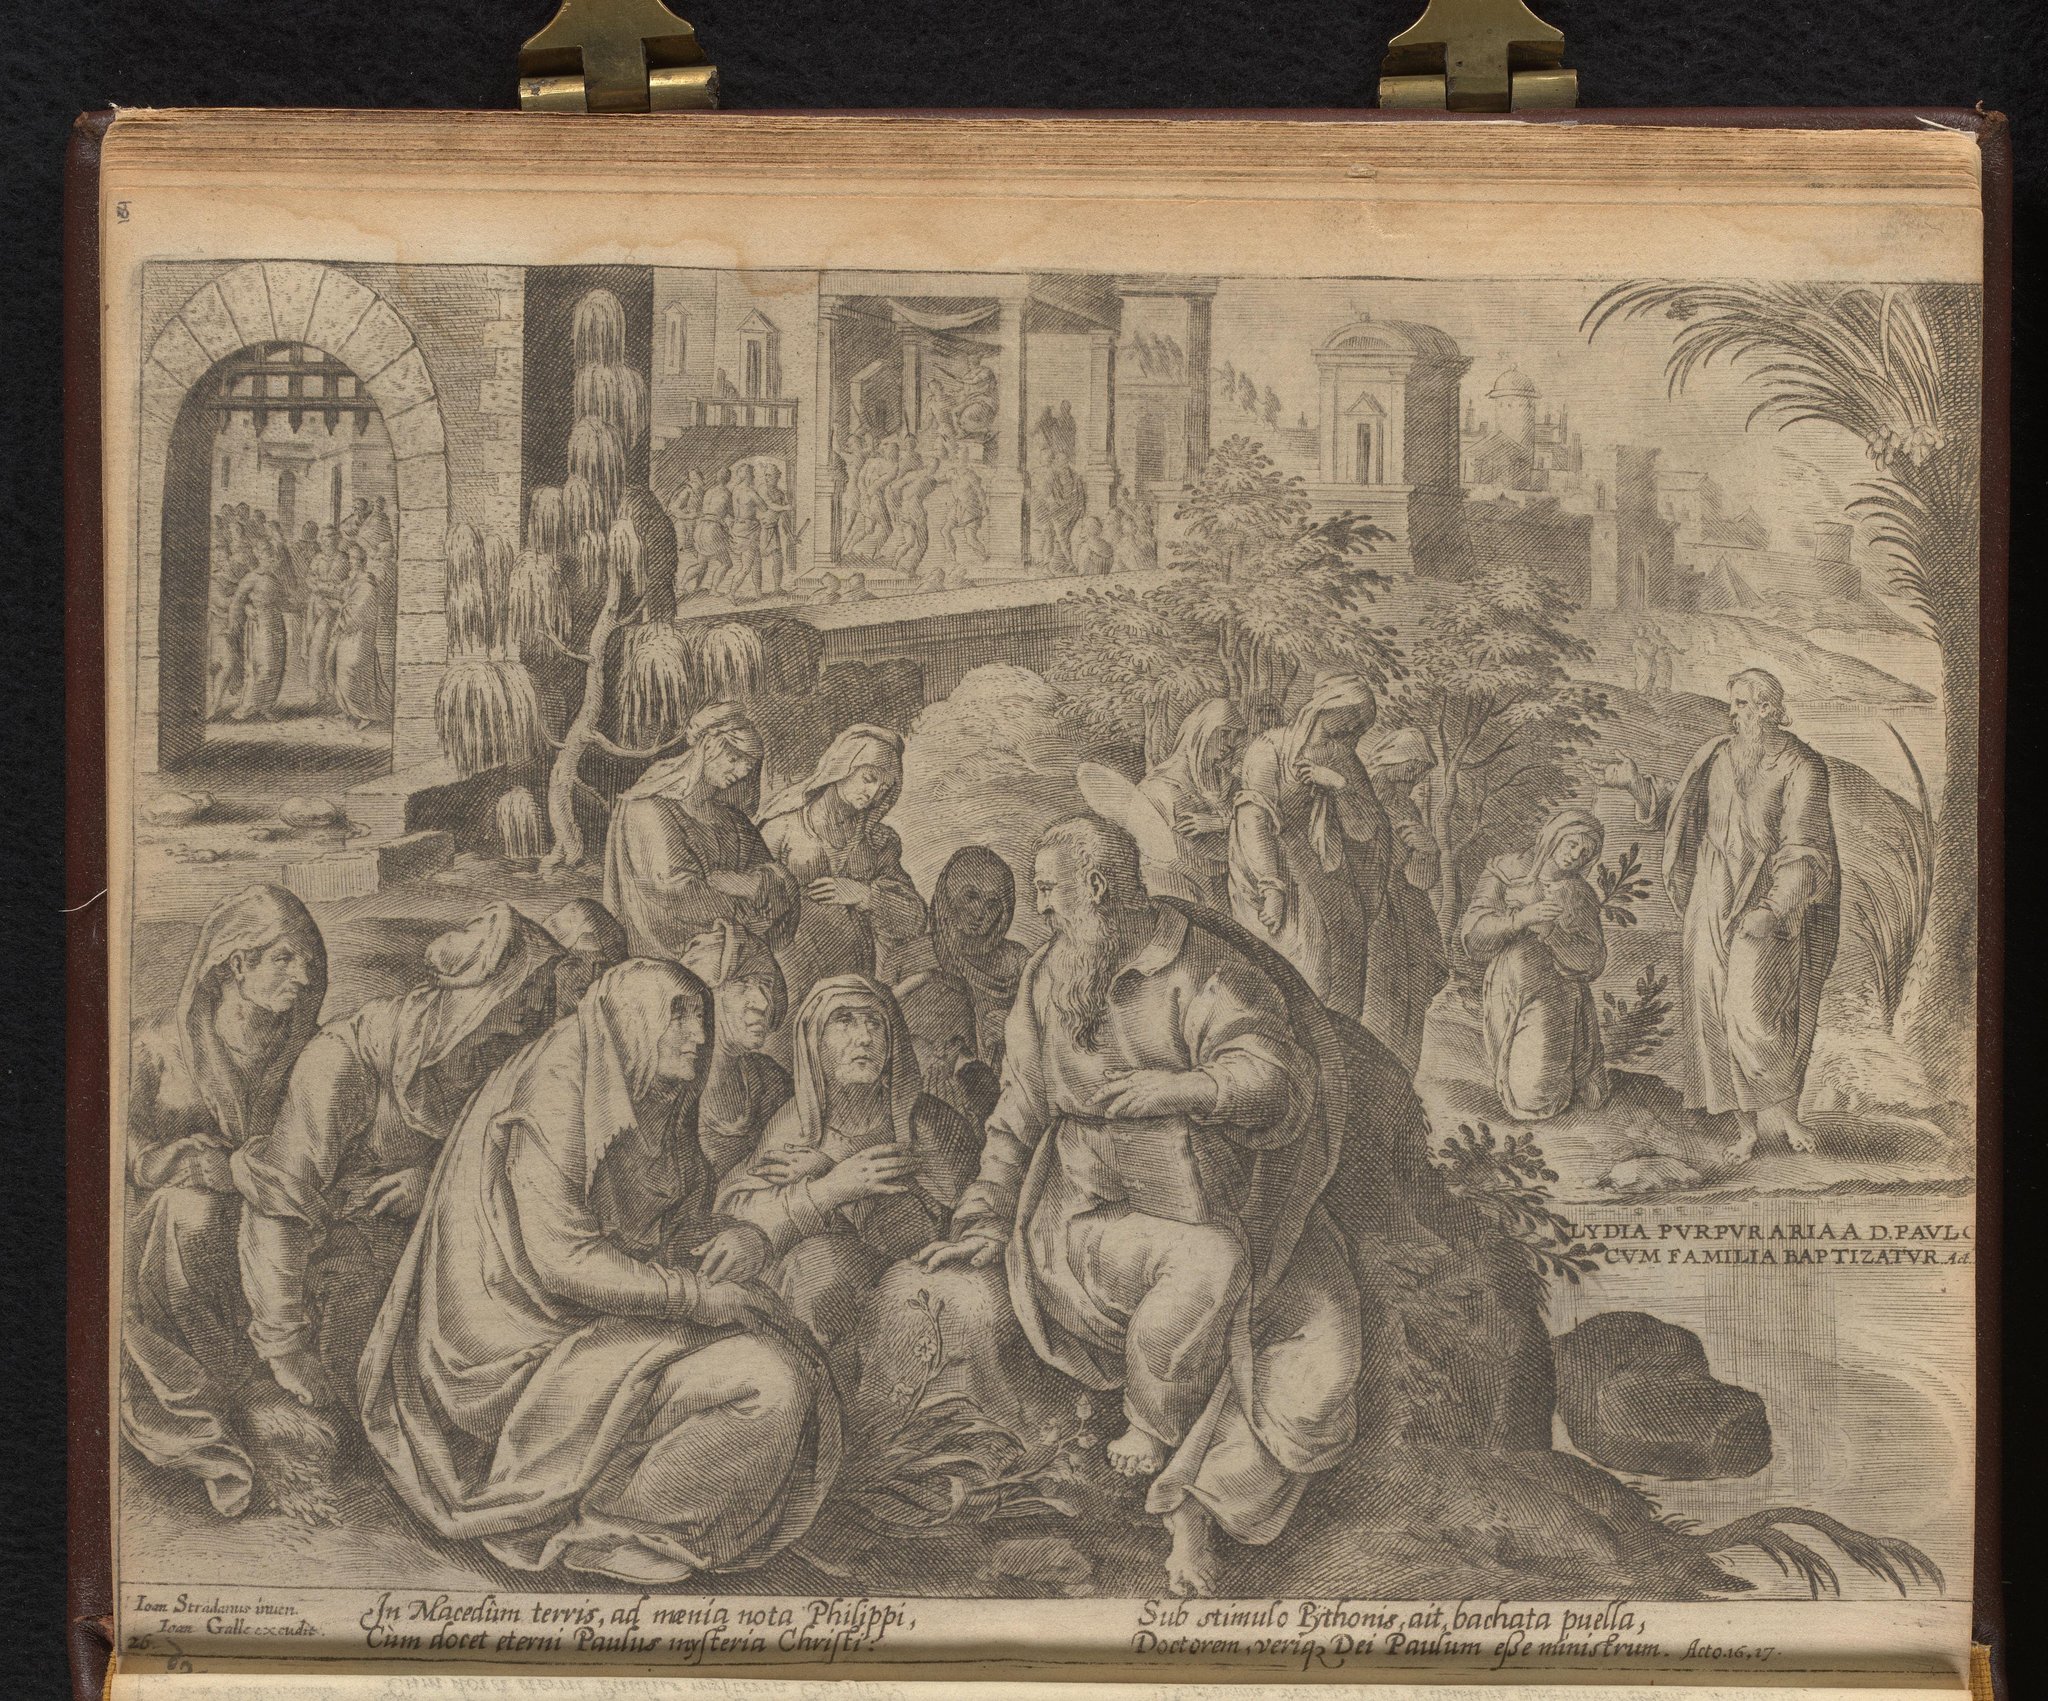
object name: titelprent, frontispice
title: Handelingen van de apostelen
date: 1582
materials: paper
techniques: engraving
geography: antwerp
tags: the conversion and baptism of lydia, a seller of purple, paul and silas brought before the magistrates by the masters of the healed woman servant, the healing of the woman servant with a divining spirit ~ paul and silas at philippi, near a river paul and silas preach to the women of philippi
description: Prent maakt deel uit van een prentbijbel.